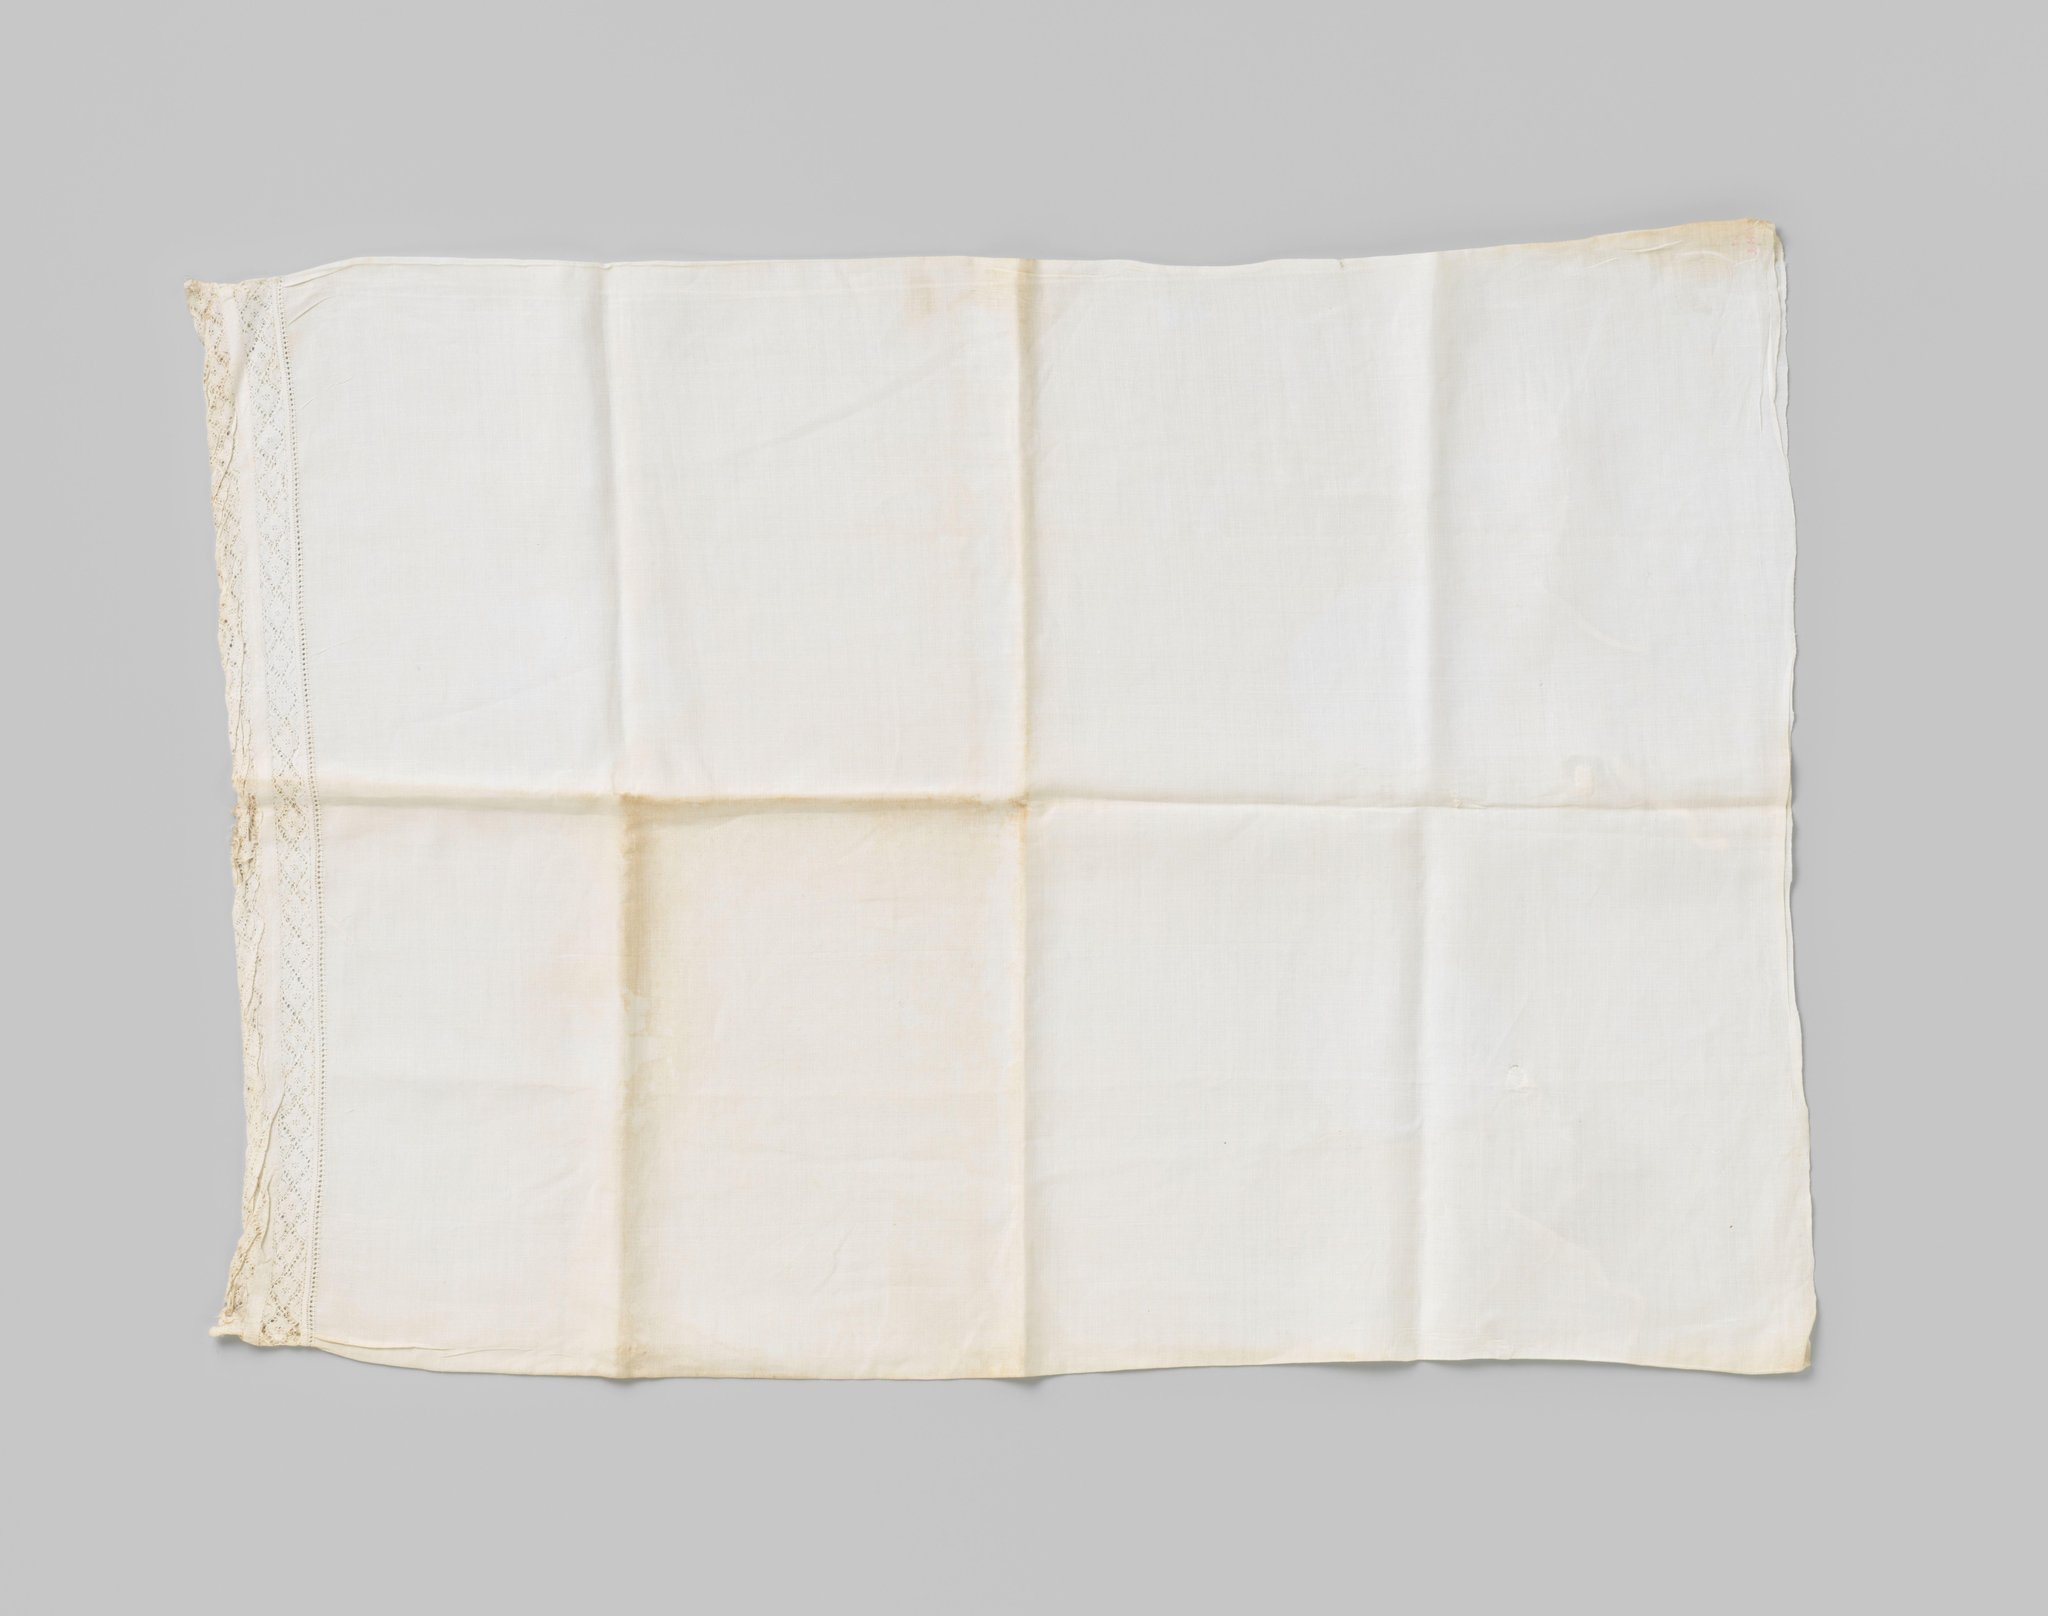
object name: pillowcase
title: Kussensloop van linnen met kloskant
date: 1600-1650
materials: linen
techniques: lace, damask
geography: southern netherlands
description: Kussensloop van linnendamast met kloskant. Model: rechthoekig met binnenbandjes aan een der korte zijden, waar ook de zelfkant loopt en aan de andere drie tussenzetsels van kloskant. Kantpatroon: dubbel brede kant in het midden en halve stroken ernaast. Vierlobbige rozetten in linnenslag wisselen af met spitsovalen, die langs de randen gehalveerd zijn. Merk: in rode kruissteek VHT/24 (Van Hasselt-T.